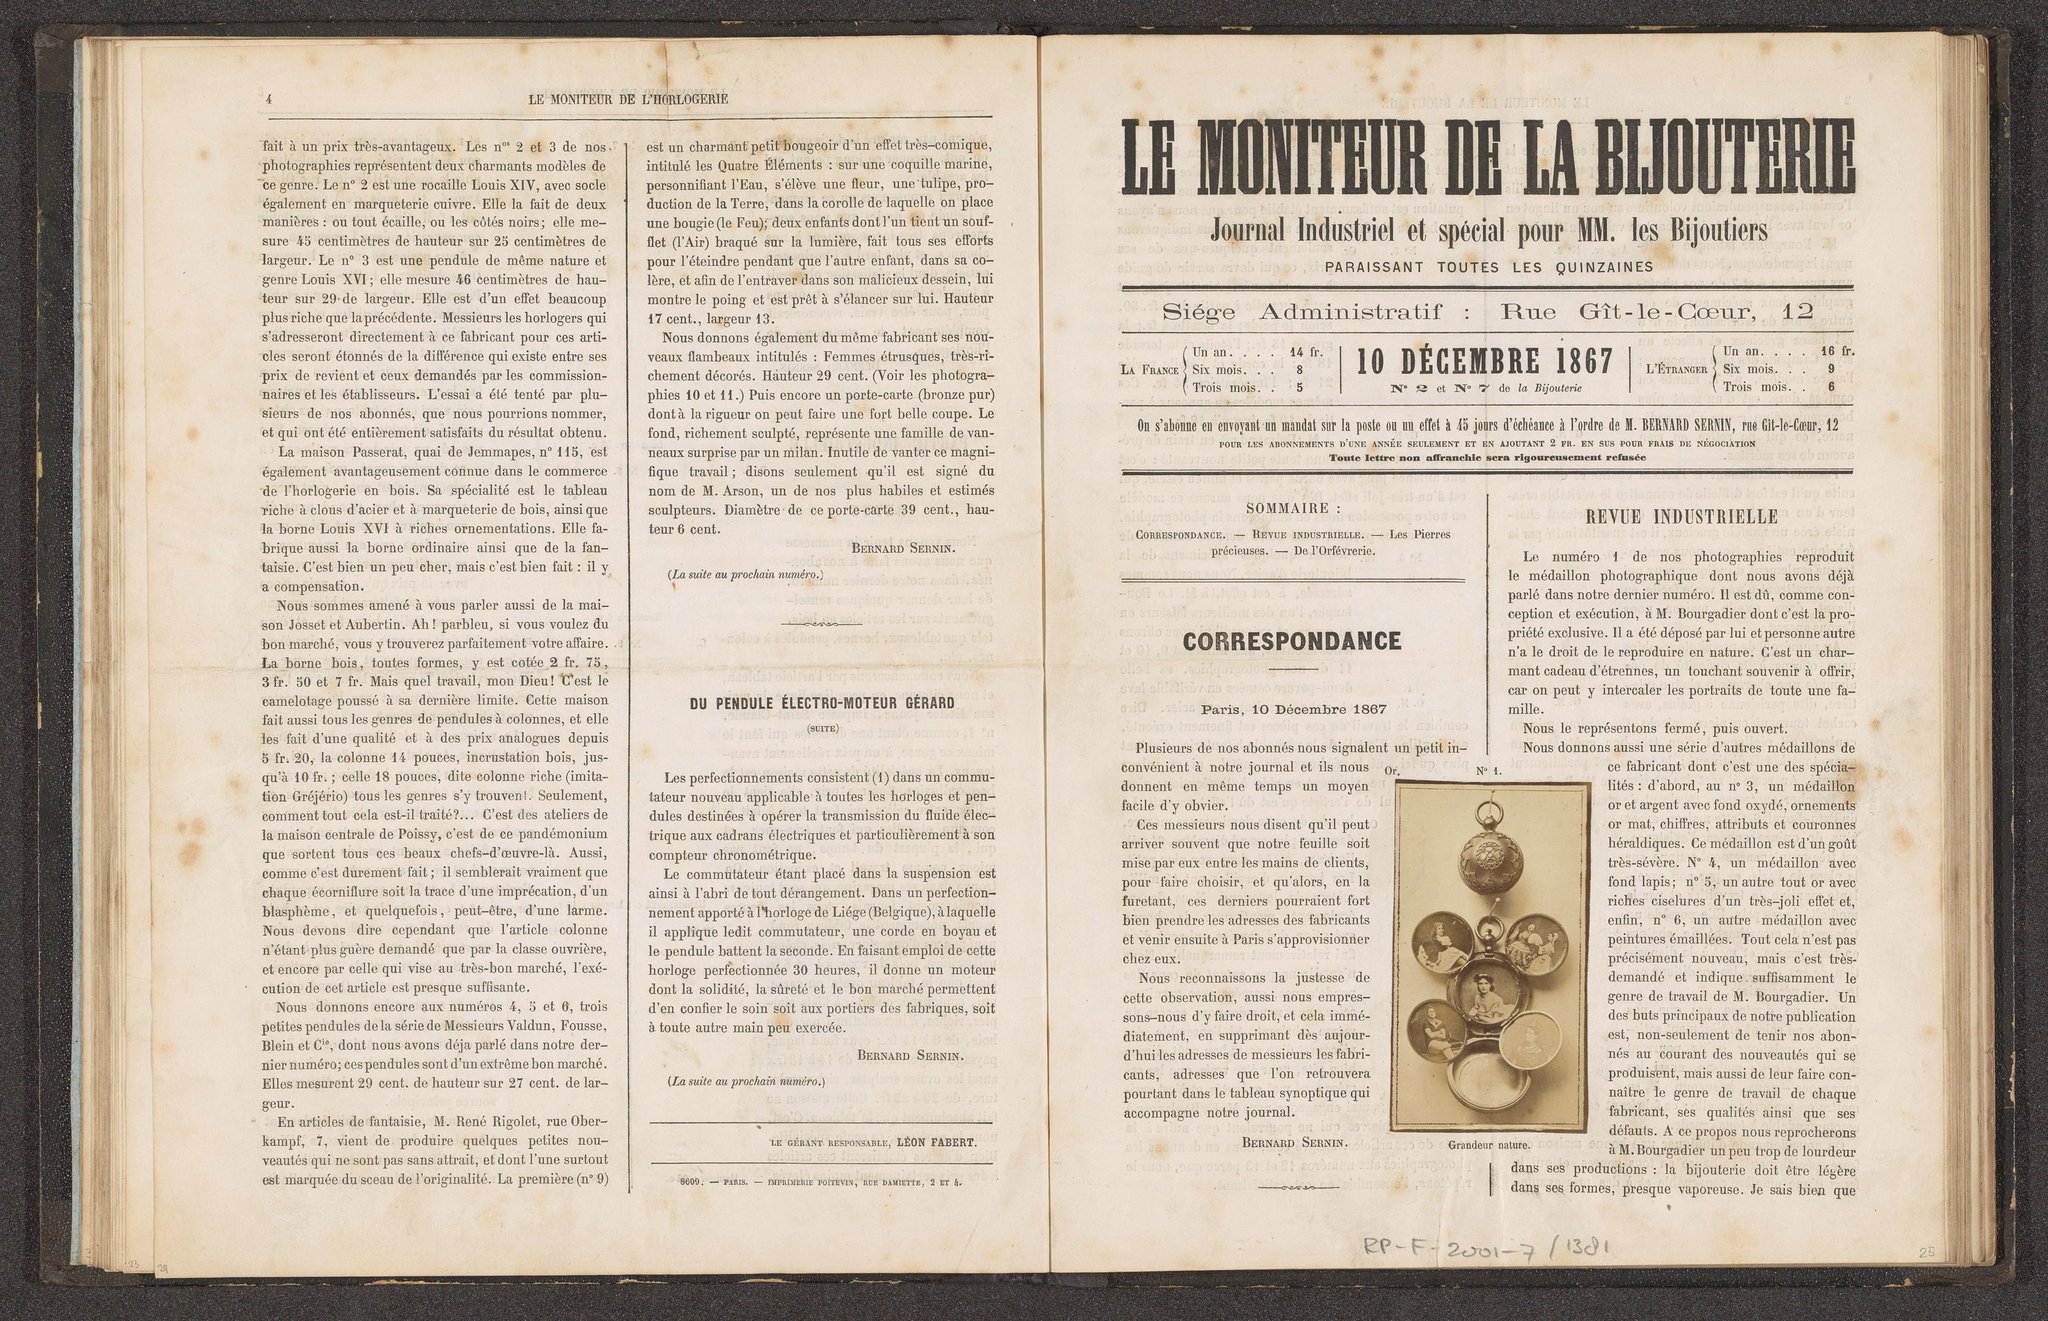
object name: page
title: Medaillons met portretten erin door M. Bourgadier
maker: Anonymous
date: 1857-1867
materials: photographic support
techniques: albumen print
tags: necklace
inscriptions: number: ‘No 1.’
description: Foto op pagina 1 van nummer 2 en 7 uit 1867.